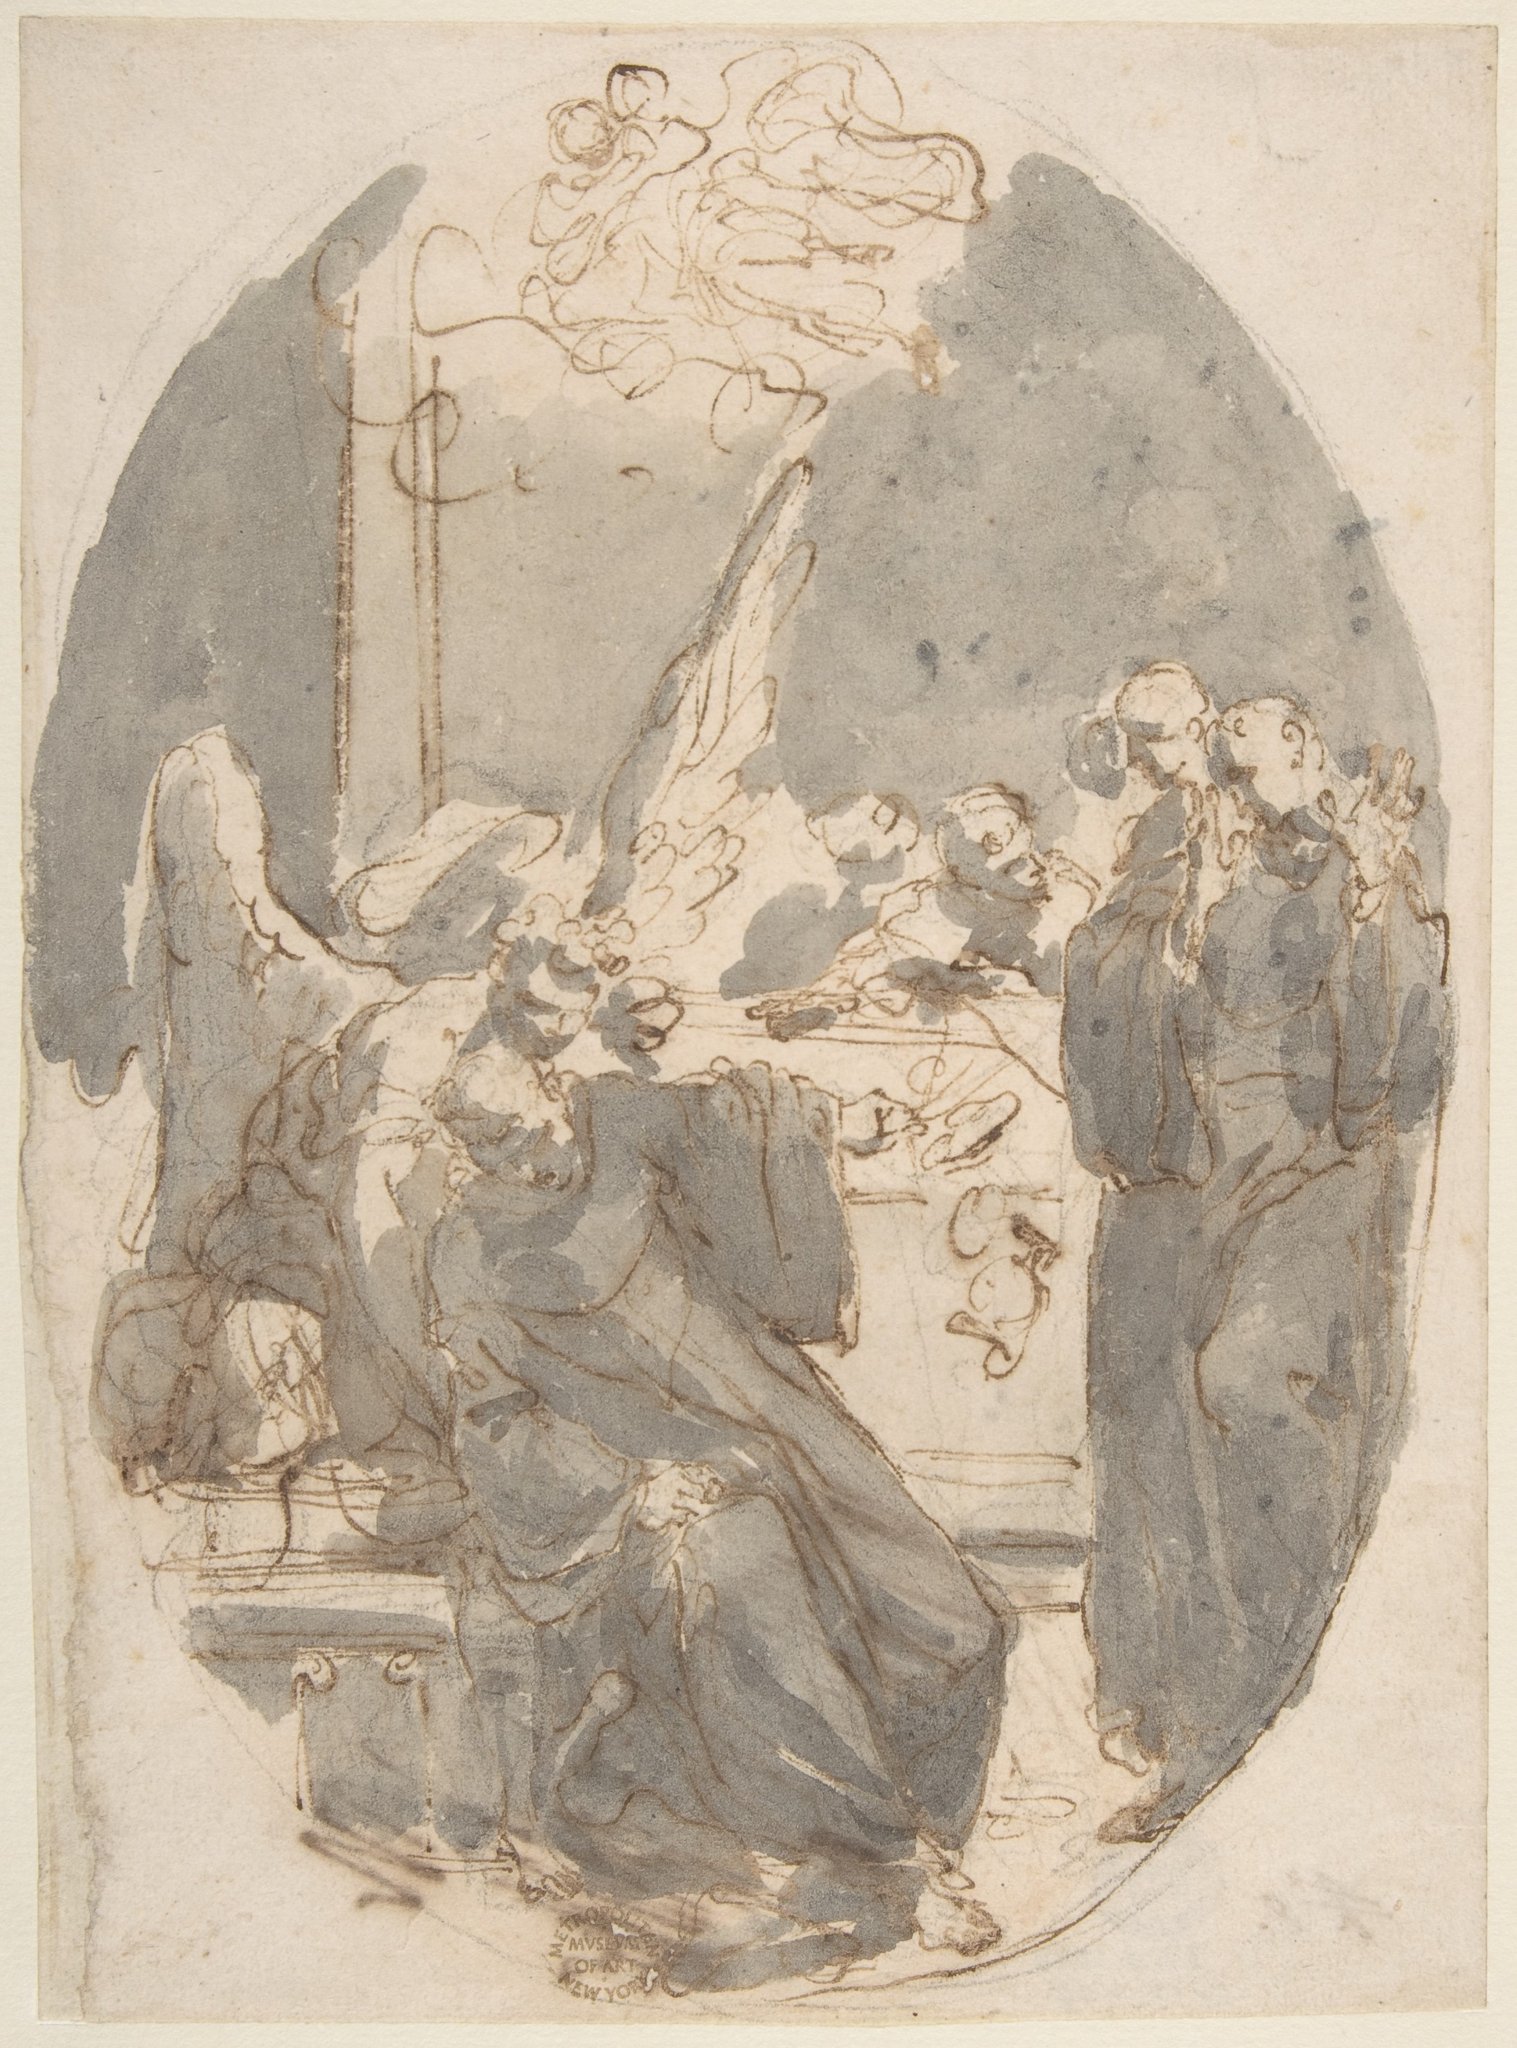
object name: drawing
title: A Dying Ecclesiastic Supported by an Angel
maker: gaetano gandolfi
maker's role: artist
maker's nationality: italian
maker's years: 1734-1802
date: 1760-1770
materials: chalk, ink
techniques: brush, pen, wash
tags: men,angels